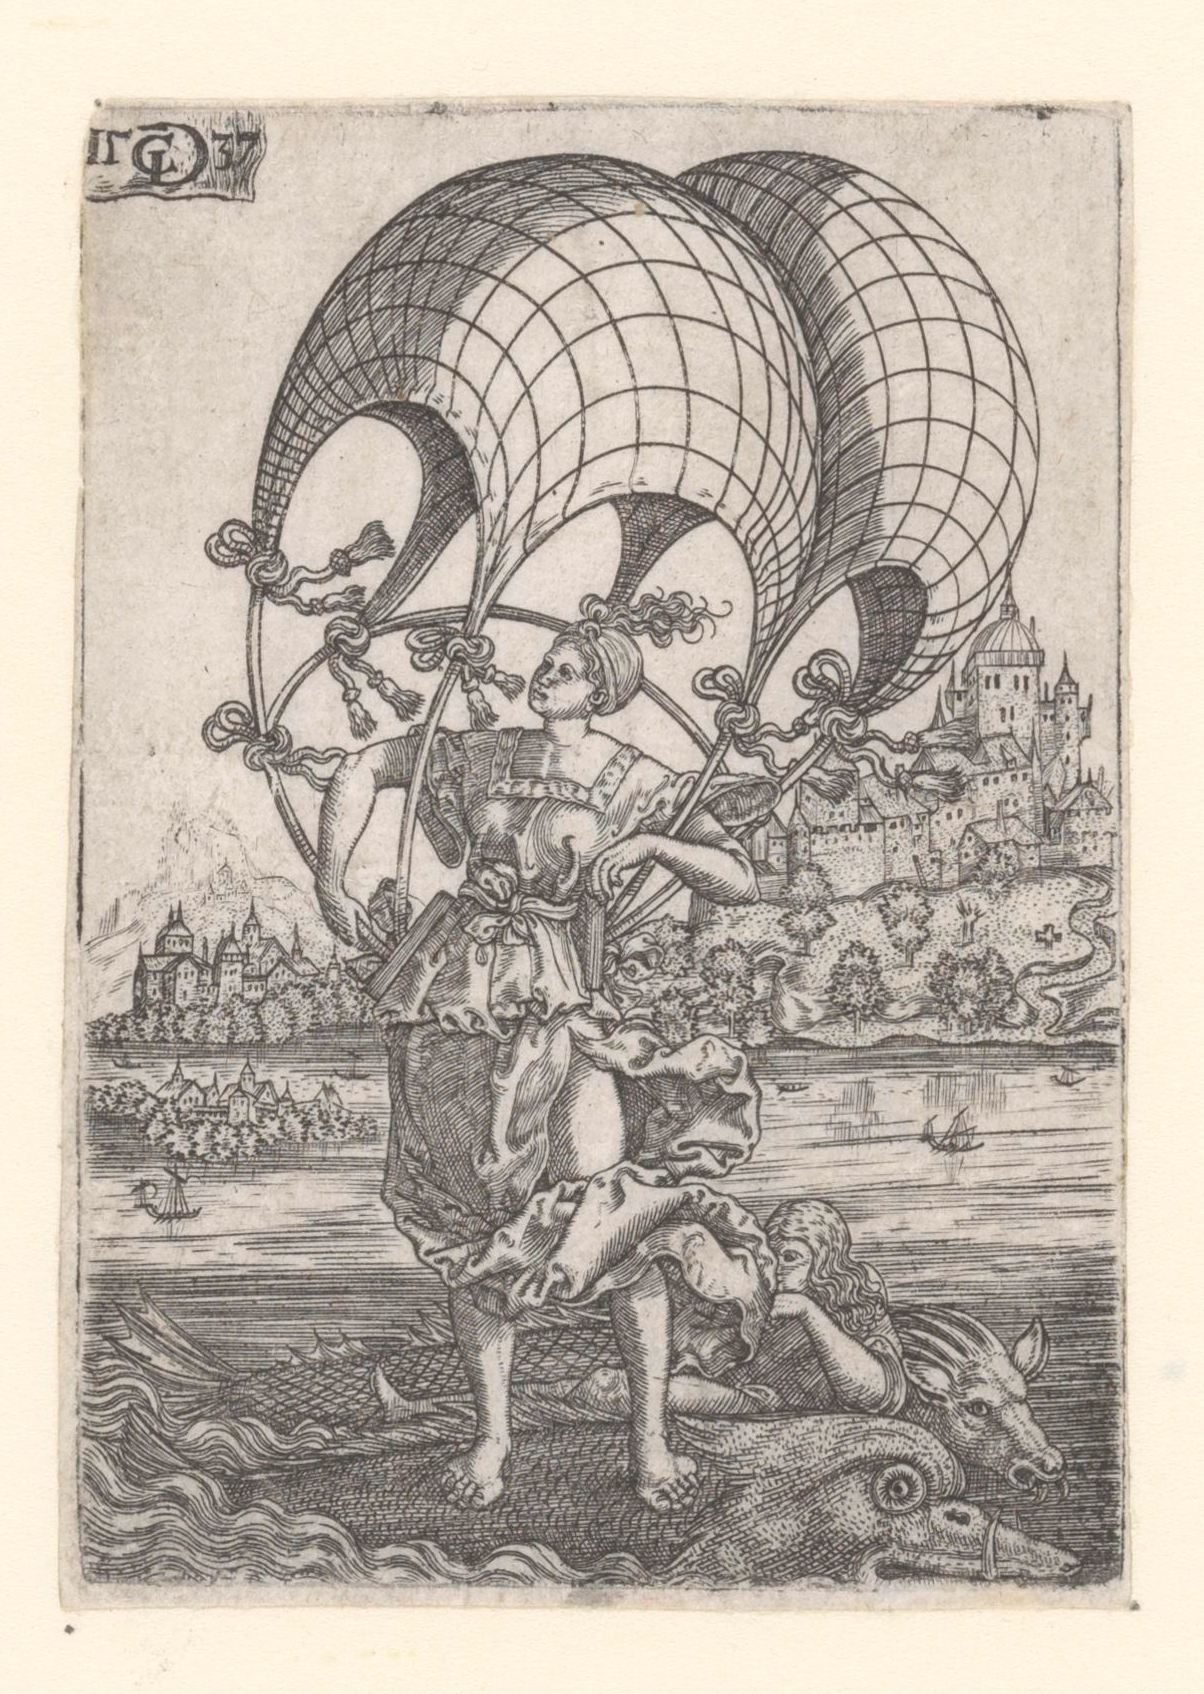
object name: ornament print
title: Galathea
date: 1537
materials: paper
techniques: engraving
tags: (story of) galatea; 'galatea' (ripa)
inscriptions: collector's mark: Lugt 2233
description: Galathea staand op een dolfijn met twee opbollende zeilen op haar rug.